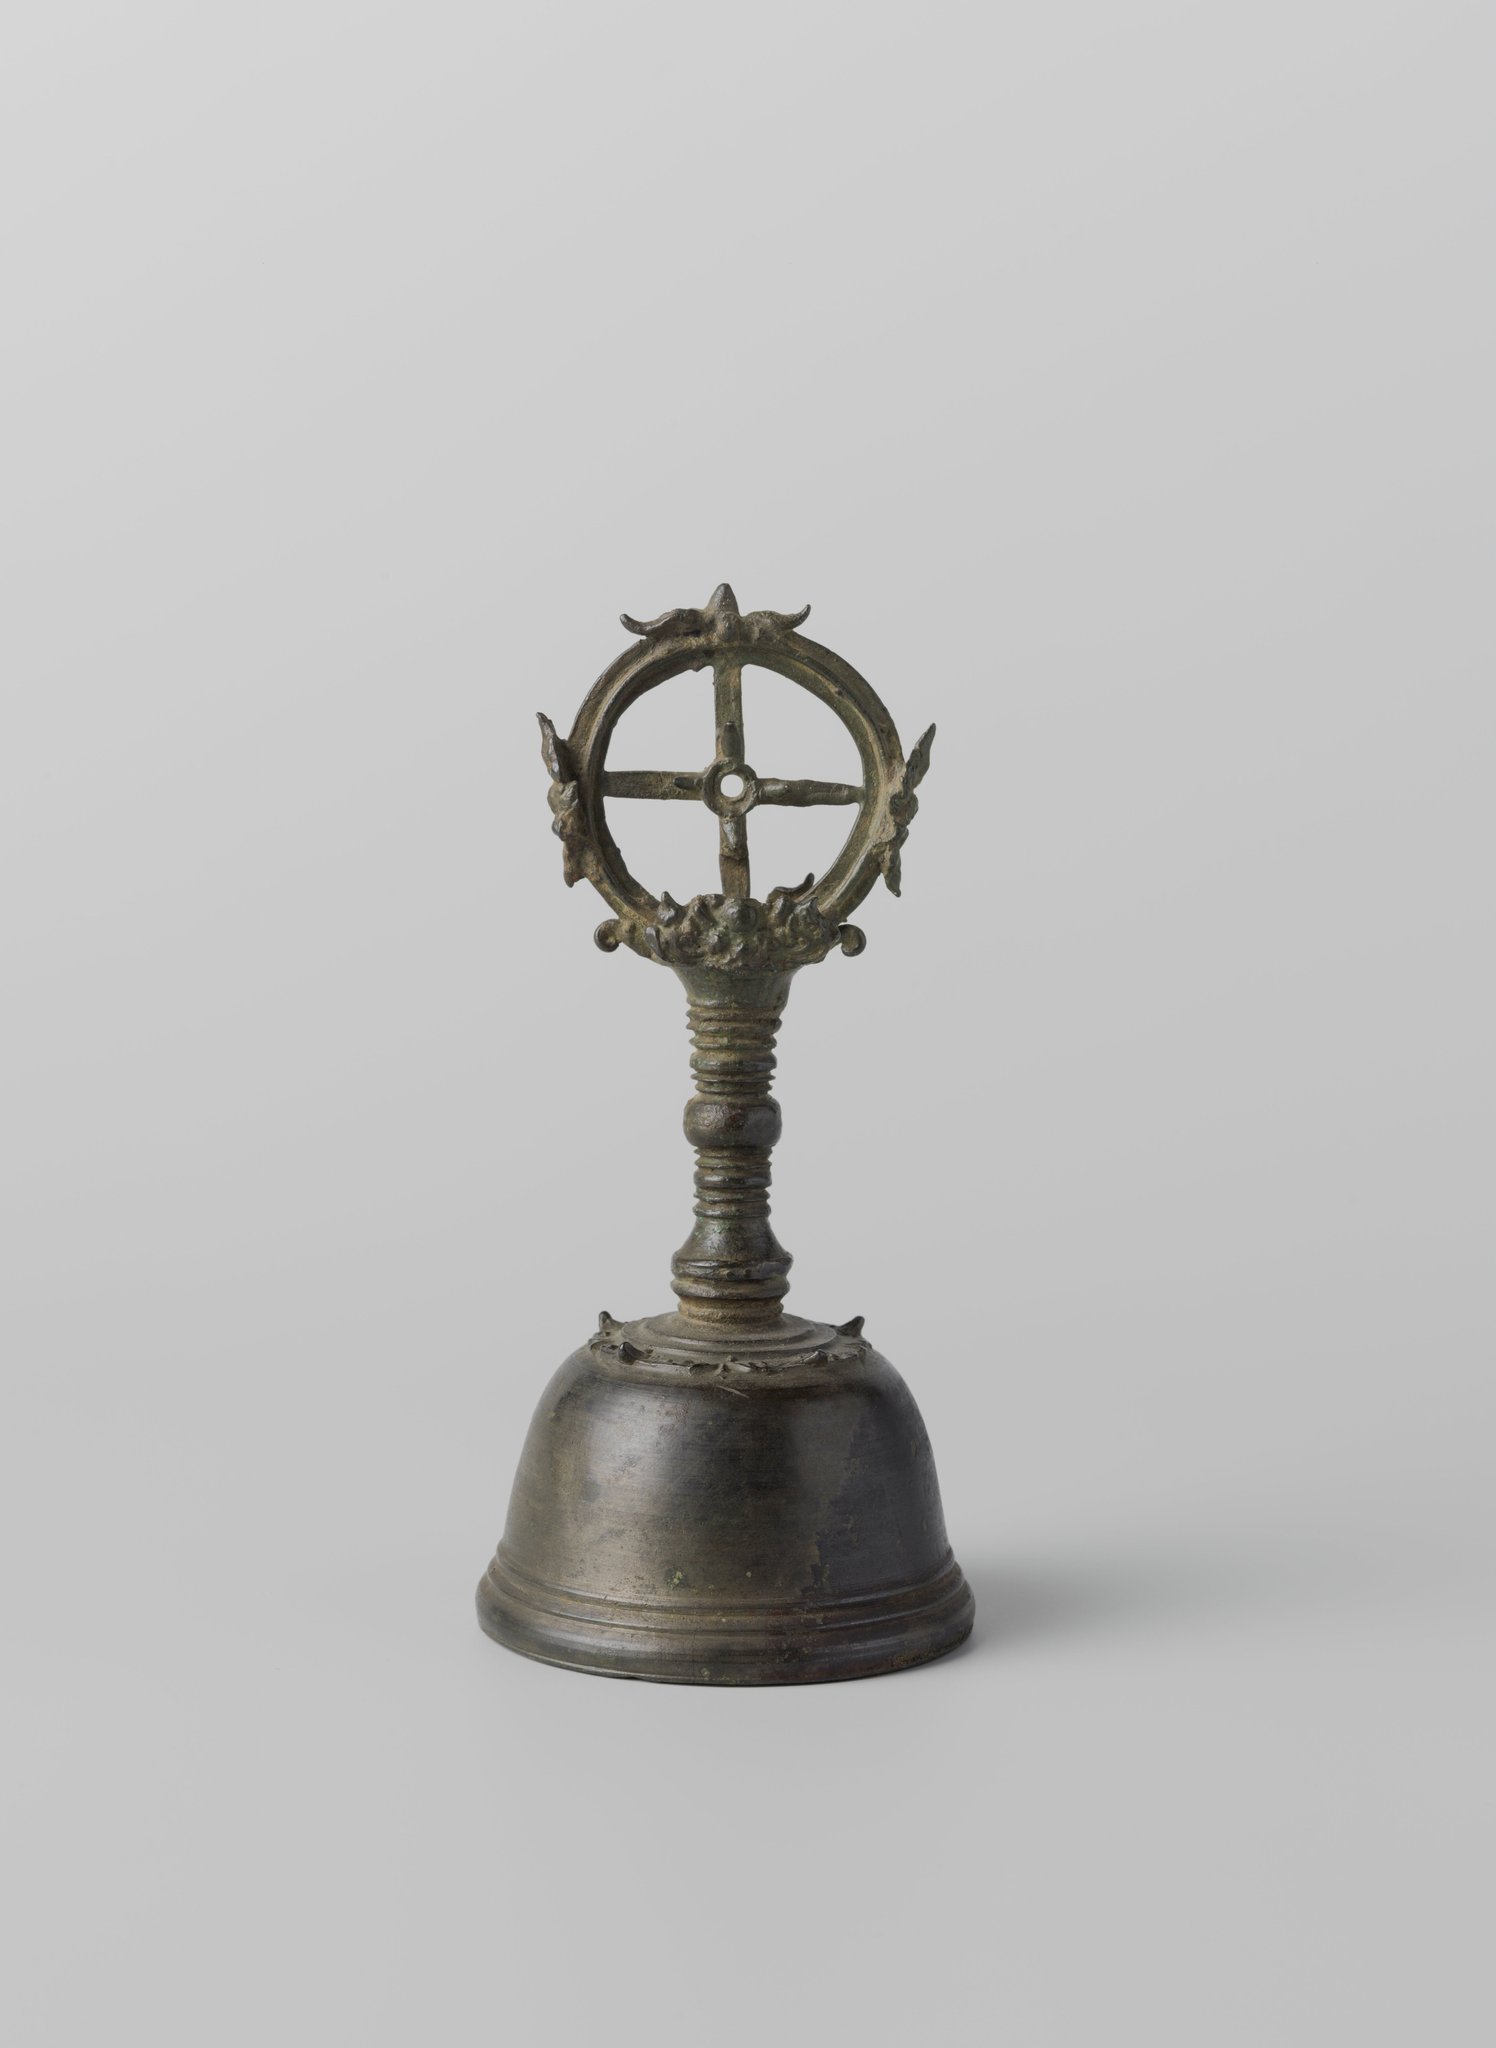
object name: jingle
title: Handbell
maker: Anonymous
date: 1200-1500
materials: bronze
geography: indonesia